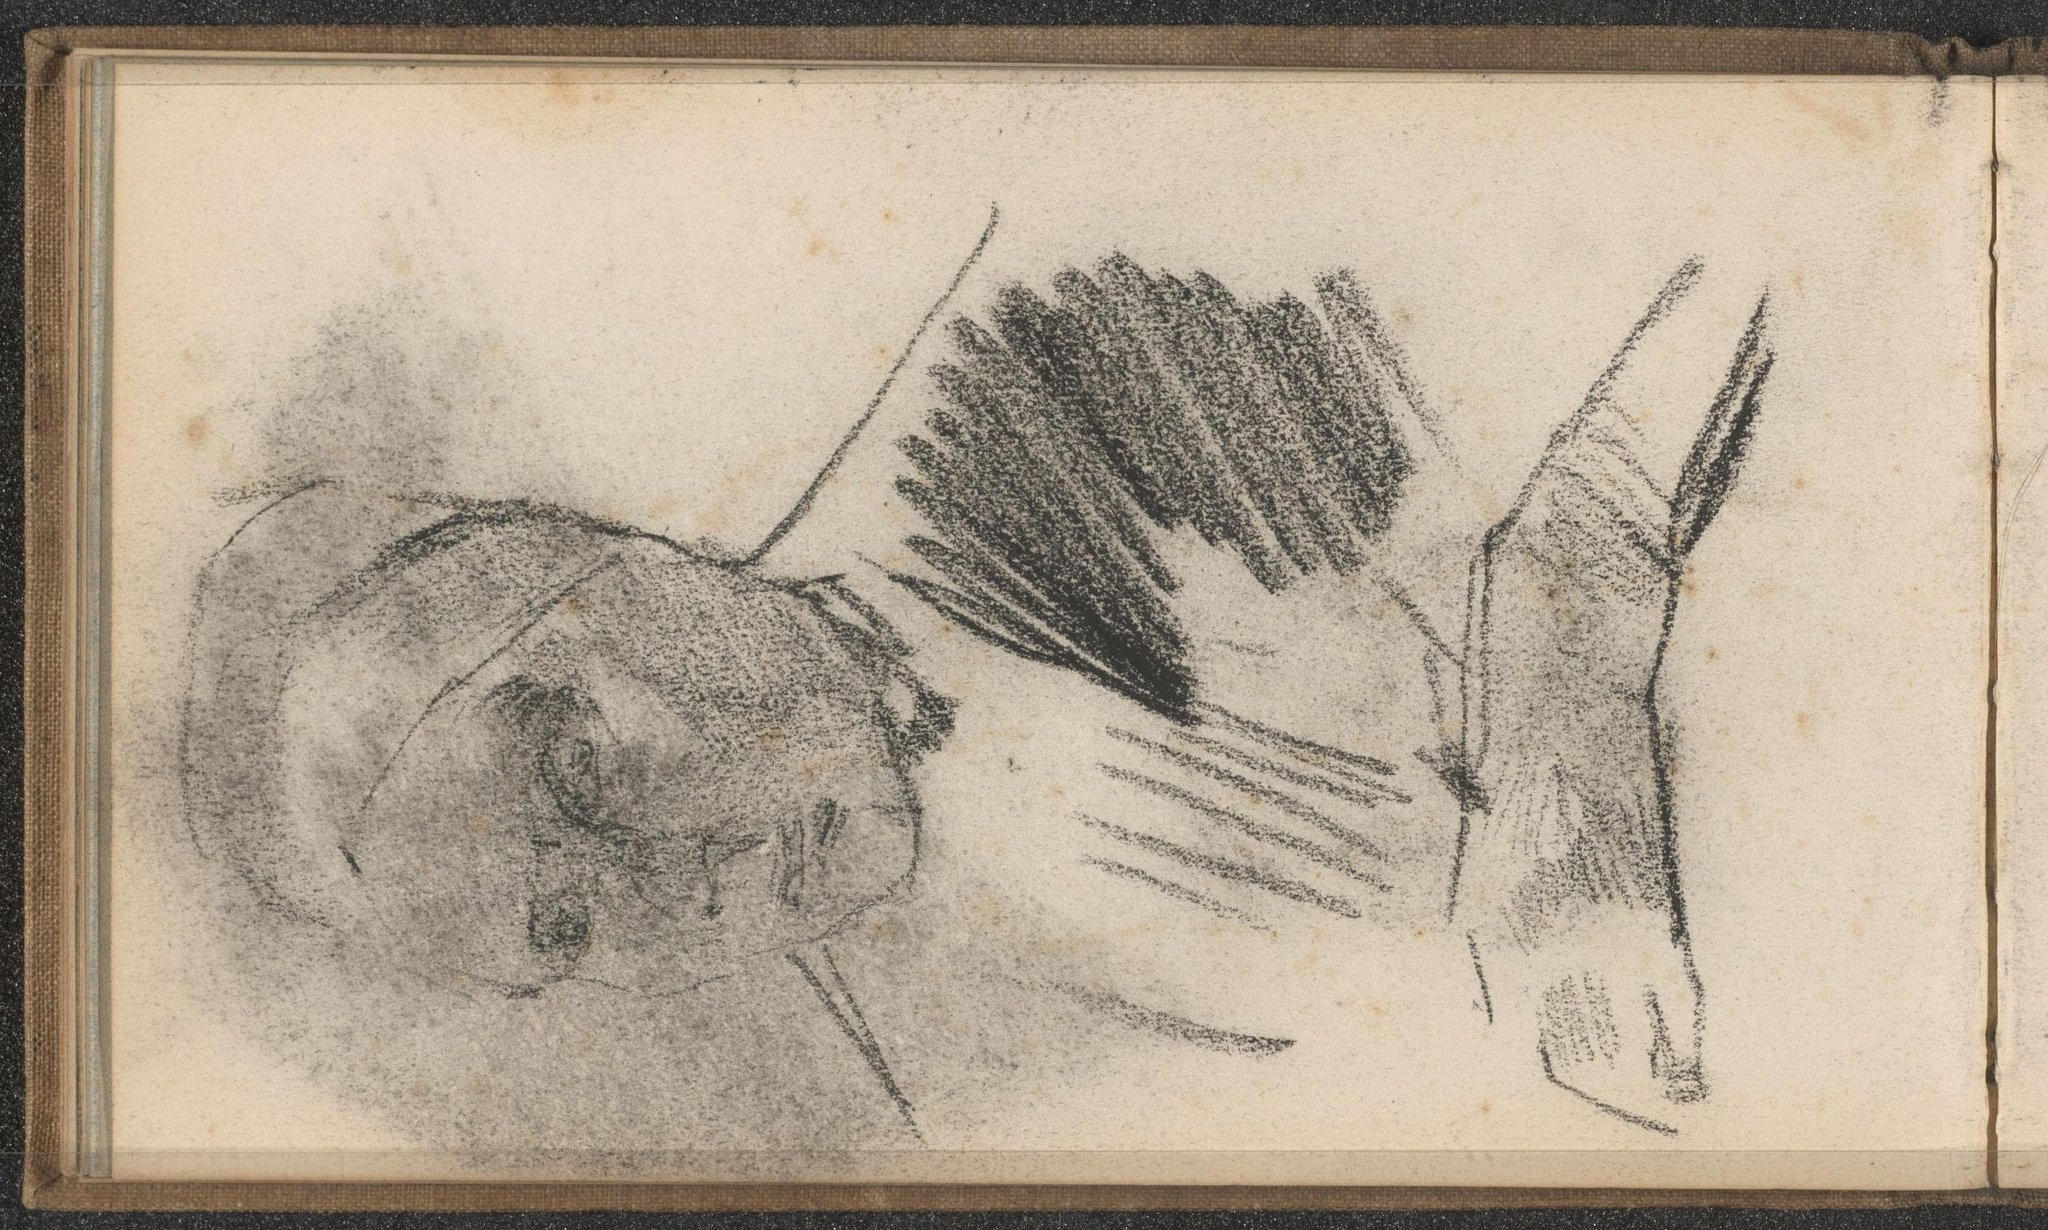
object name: sketchbook leaf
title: Vrouw met hoofdbedekking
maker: george hendrik breitner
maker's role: draughtsman, painter, print maker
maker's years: 1857-1923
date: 1883-1885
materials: chalk, paper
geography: drenthe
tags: folk costume, regional costume (+ women's clothes), adult woman, head-gear (+ women's clothes)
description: Pagina 57 uit een schetsboek met 48 bladen.